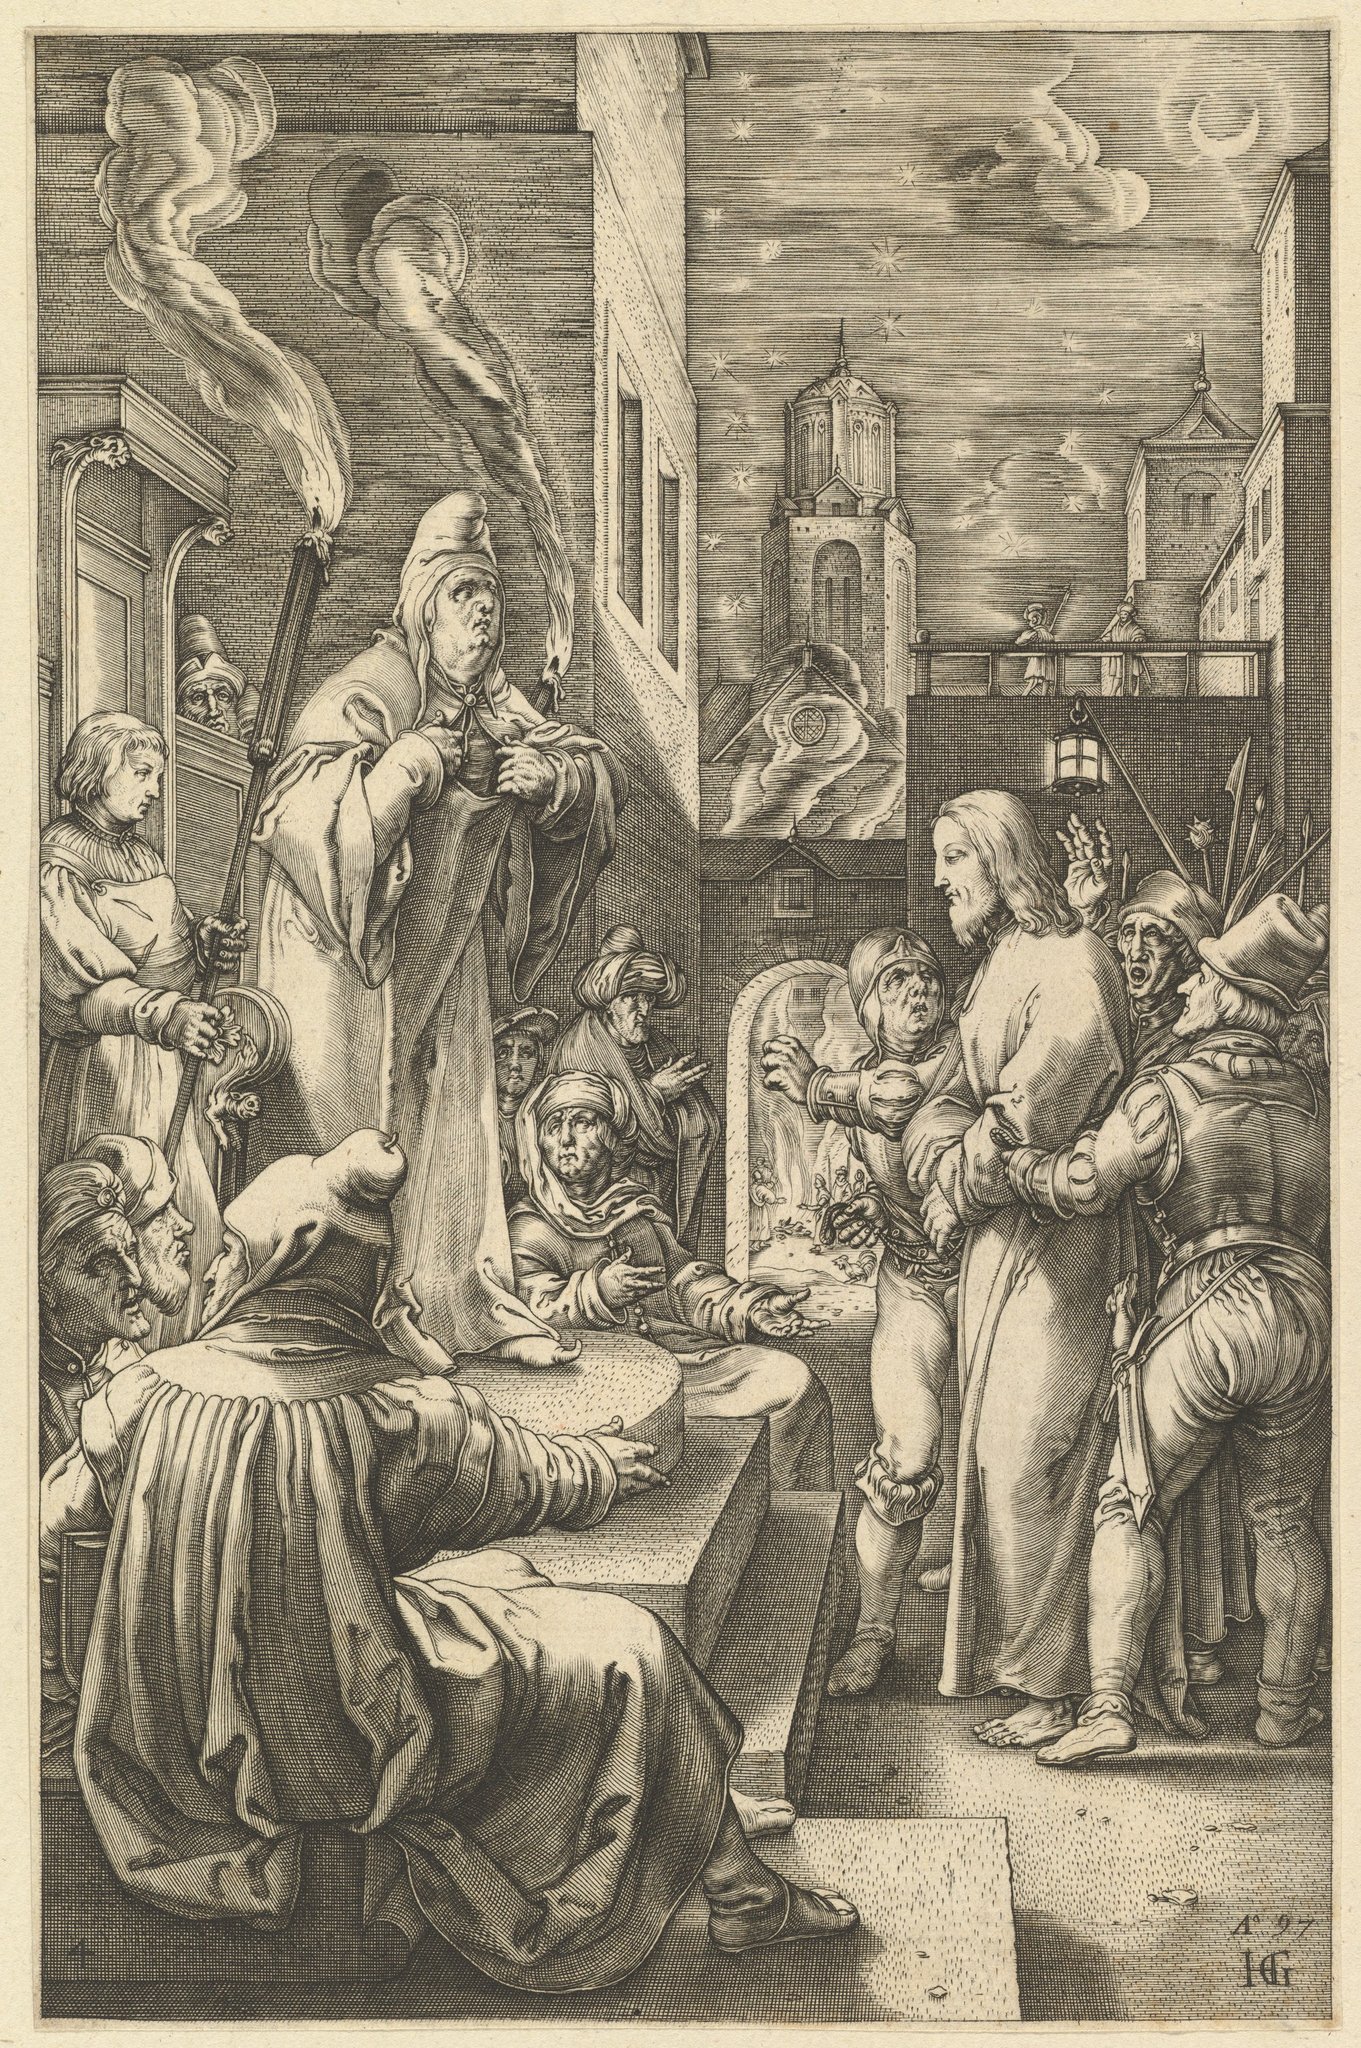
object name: print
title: Christ Before Caiaphas, from "The Passion of Christ"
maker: Anonymous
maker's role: artist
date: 1598-1617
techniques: engraving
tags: men,women,christ